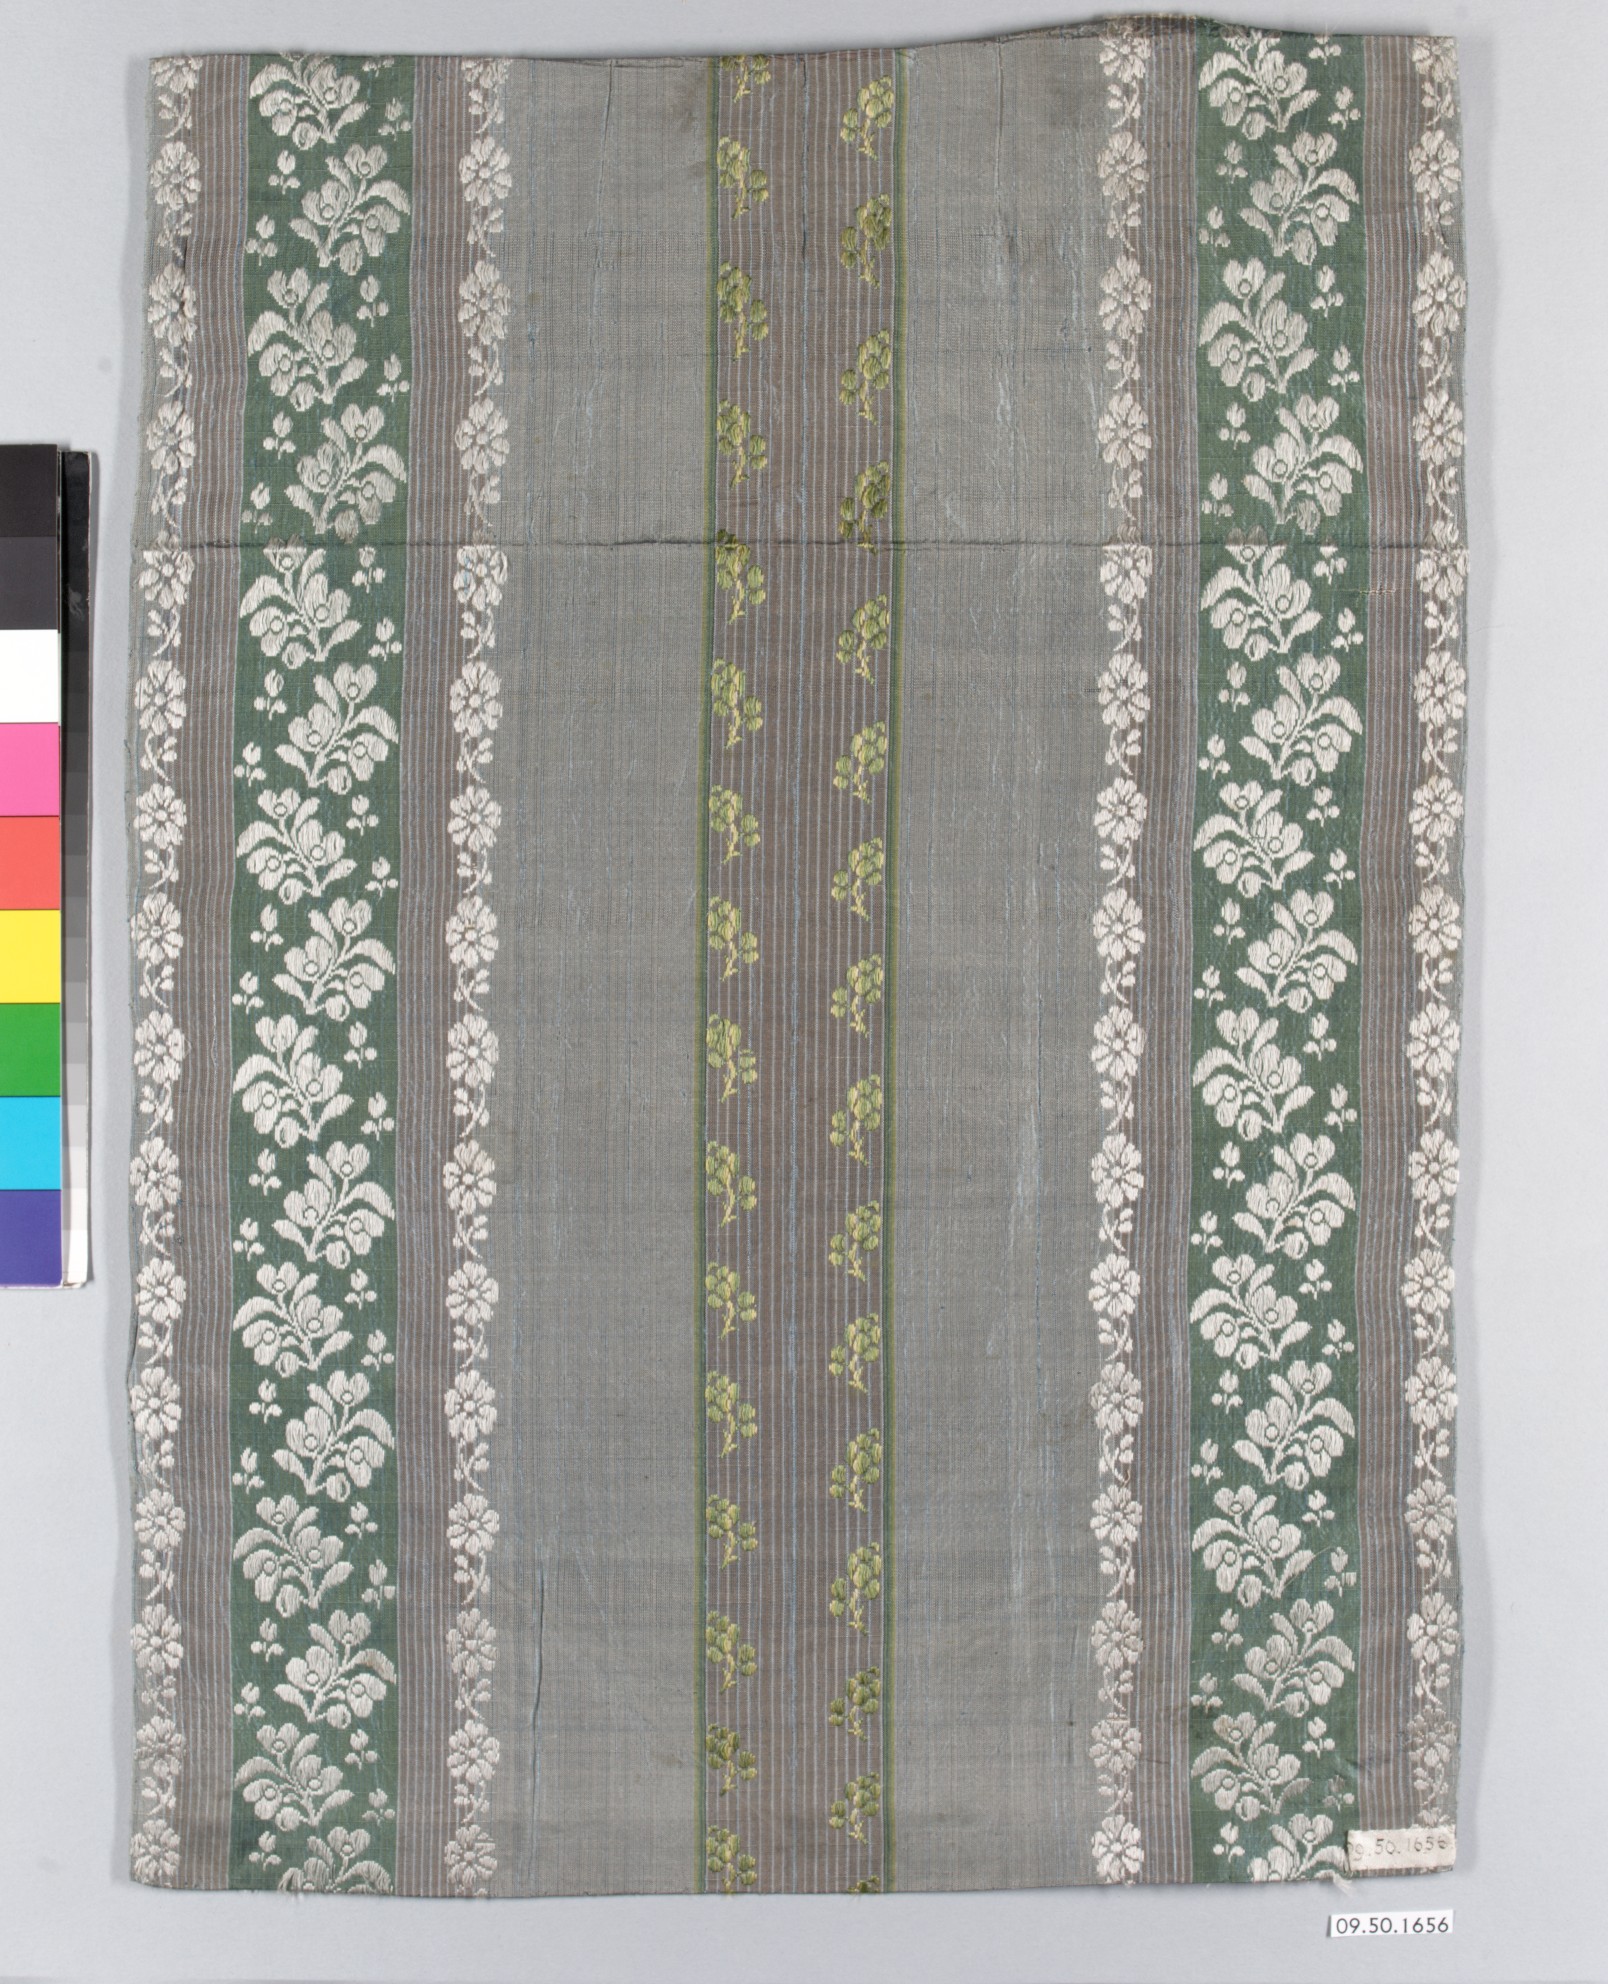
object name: piece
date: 1775-1790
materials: silk